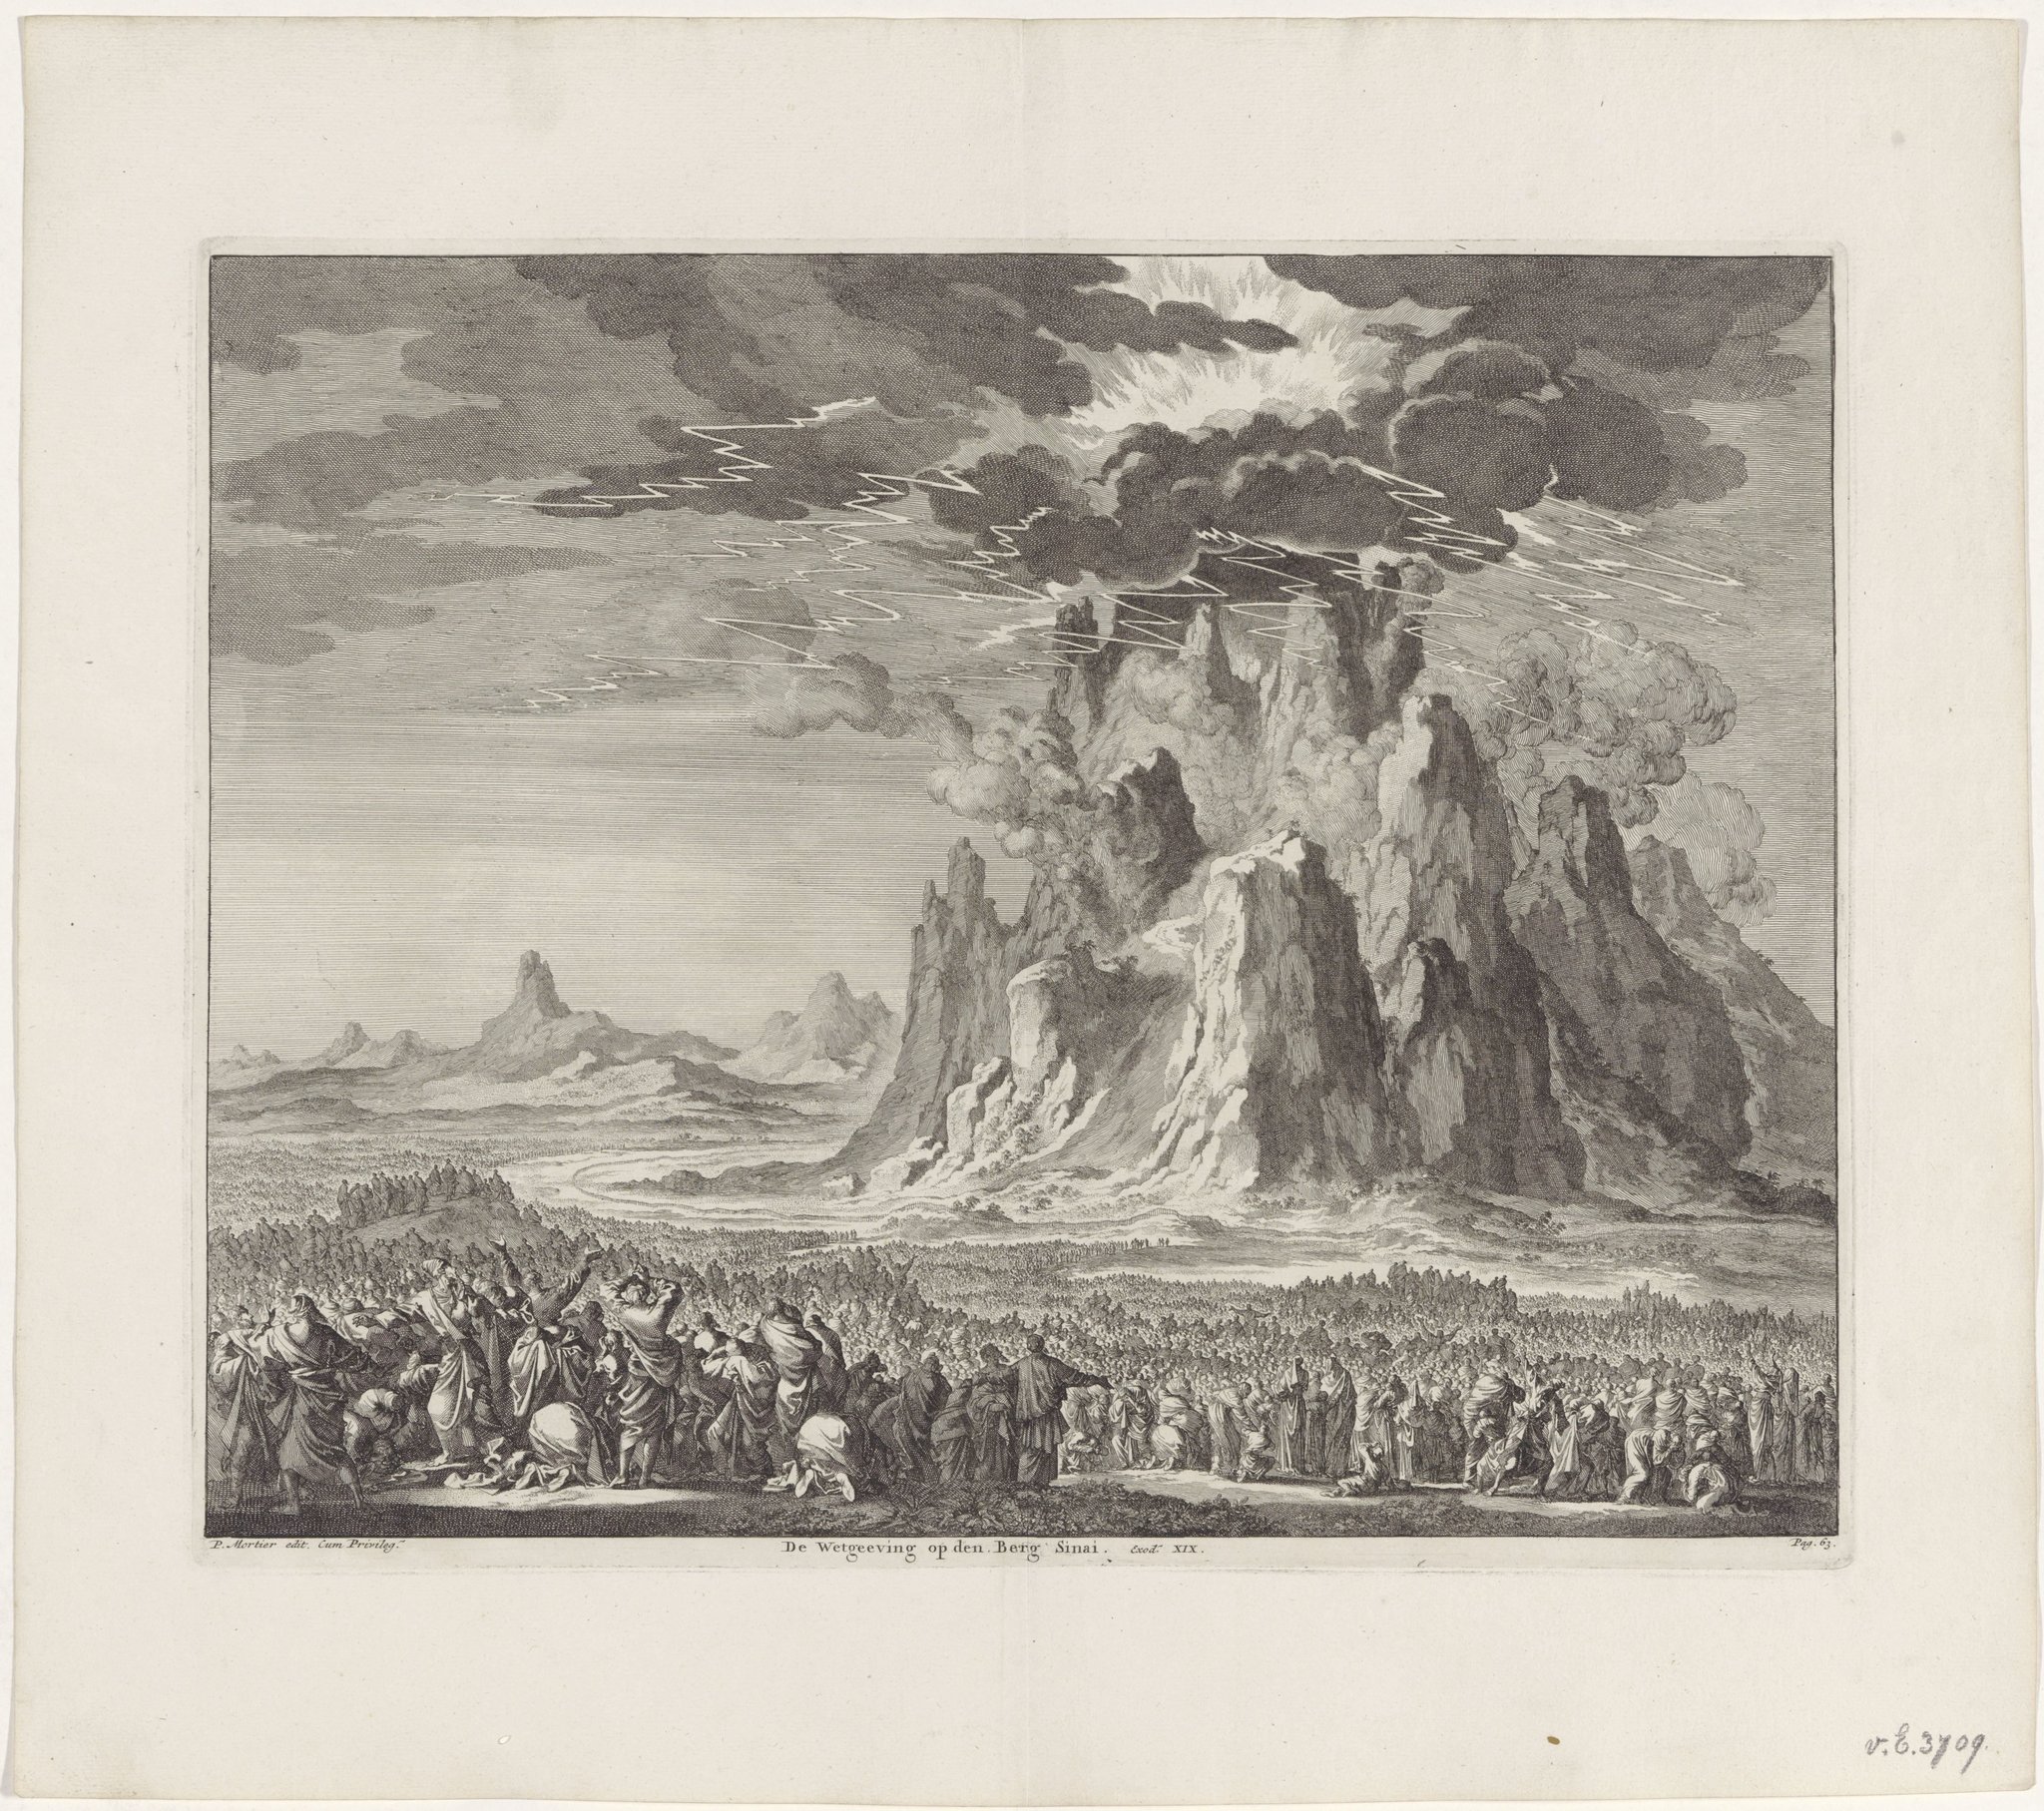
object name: print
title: Wetgeving op de berg Sinaï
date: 1708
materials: paper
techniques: etching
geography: amsterdam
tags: mount sinai is covered by a thick cloud, thunder and lightning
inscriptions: collector's mark: Lugt 2228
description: Mozes spreekt met God op de berg Sinaï. Het Joodse volk op de voorgrond raakt in paniek bij het horen van donderslagen en het zien van lichtflitsen en van rook die uit de berg komt (Ex. 20:21).